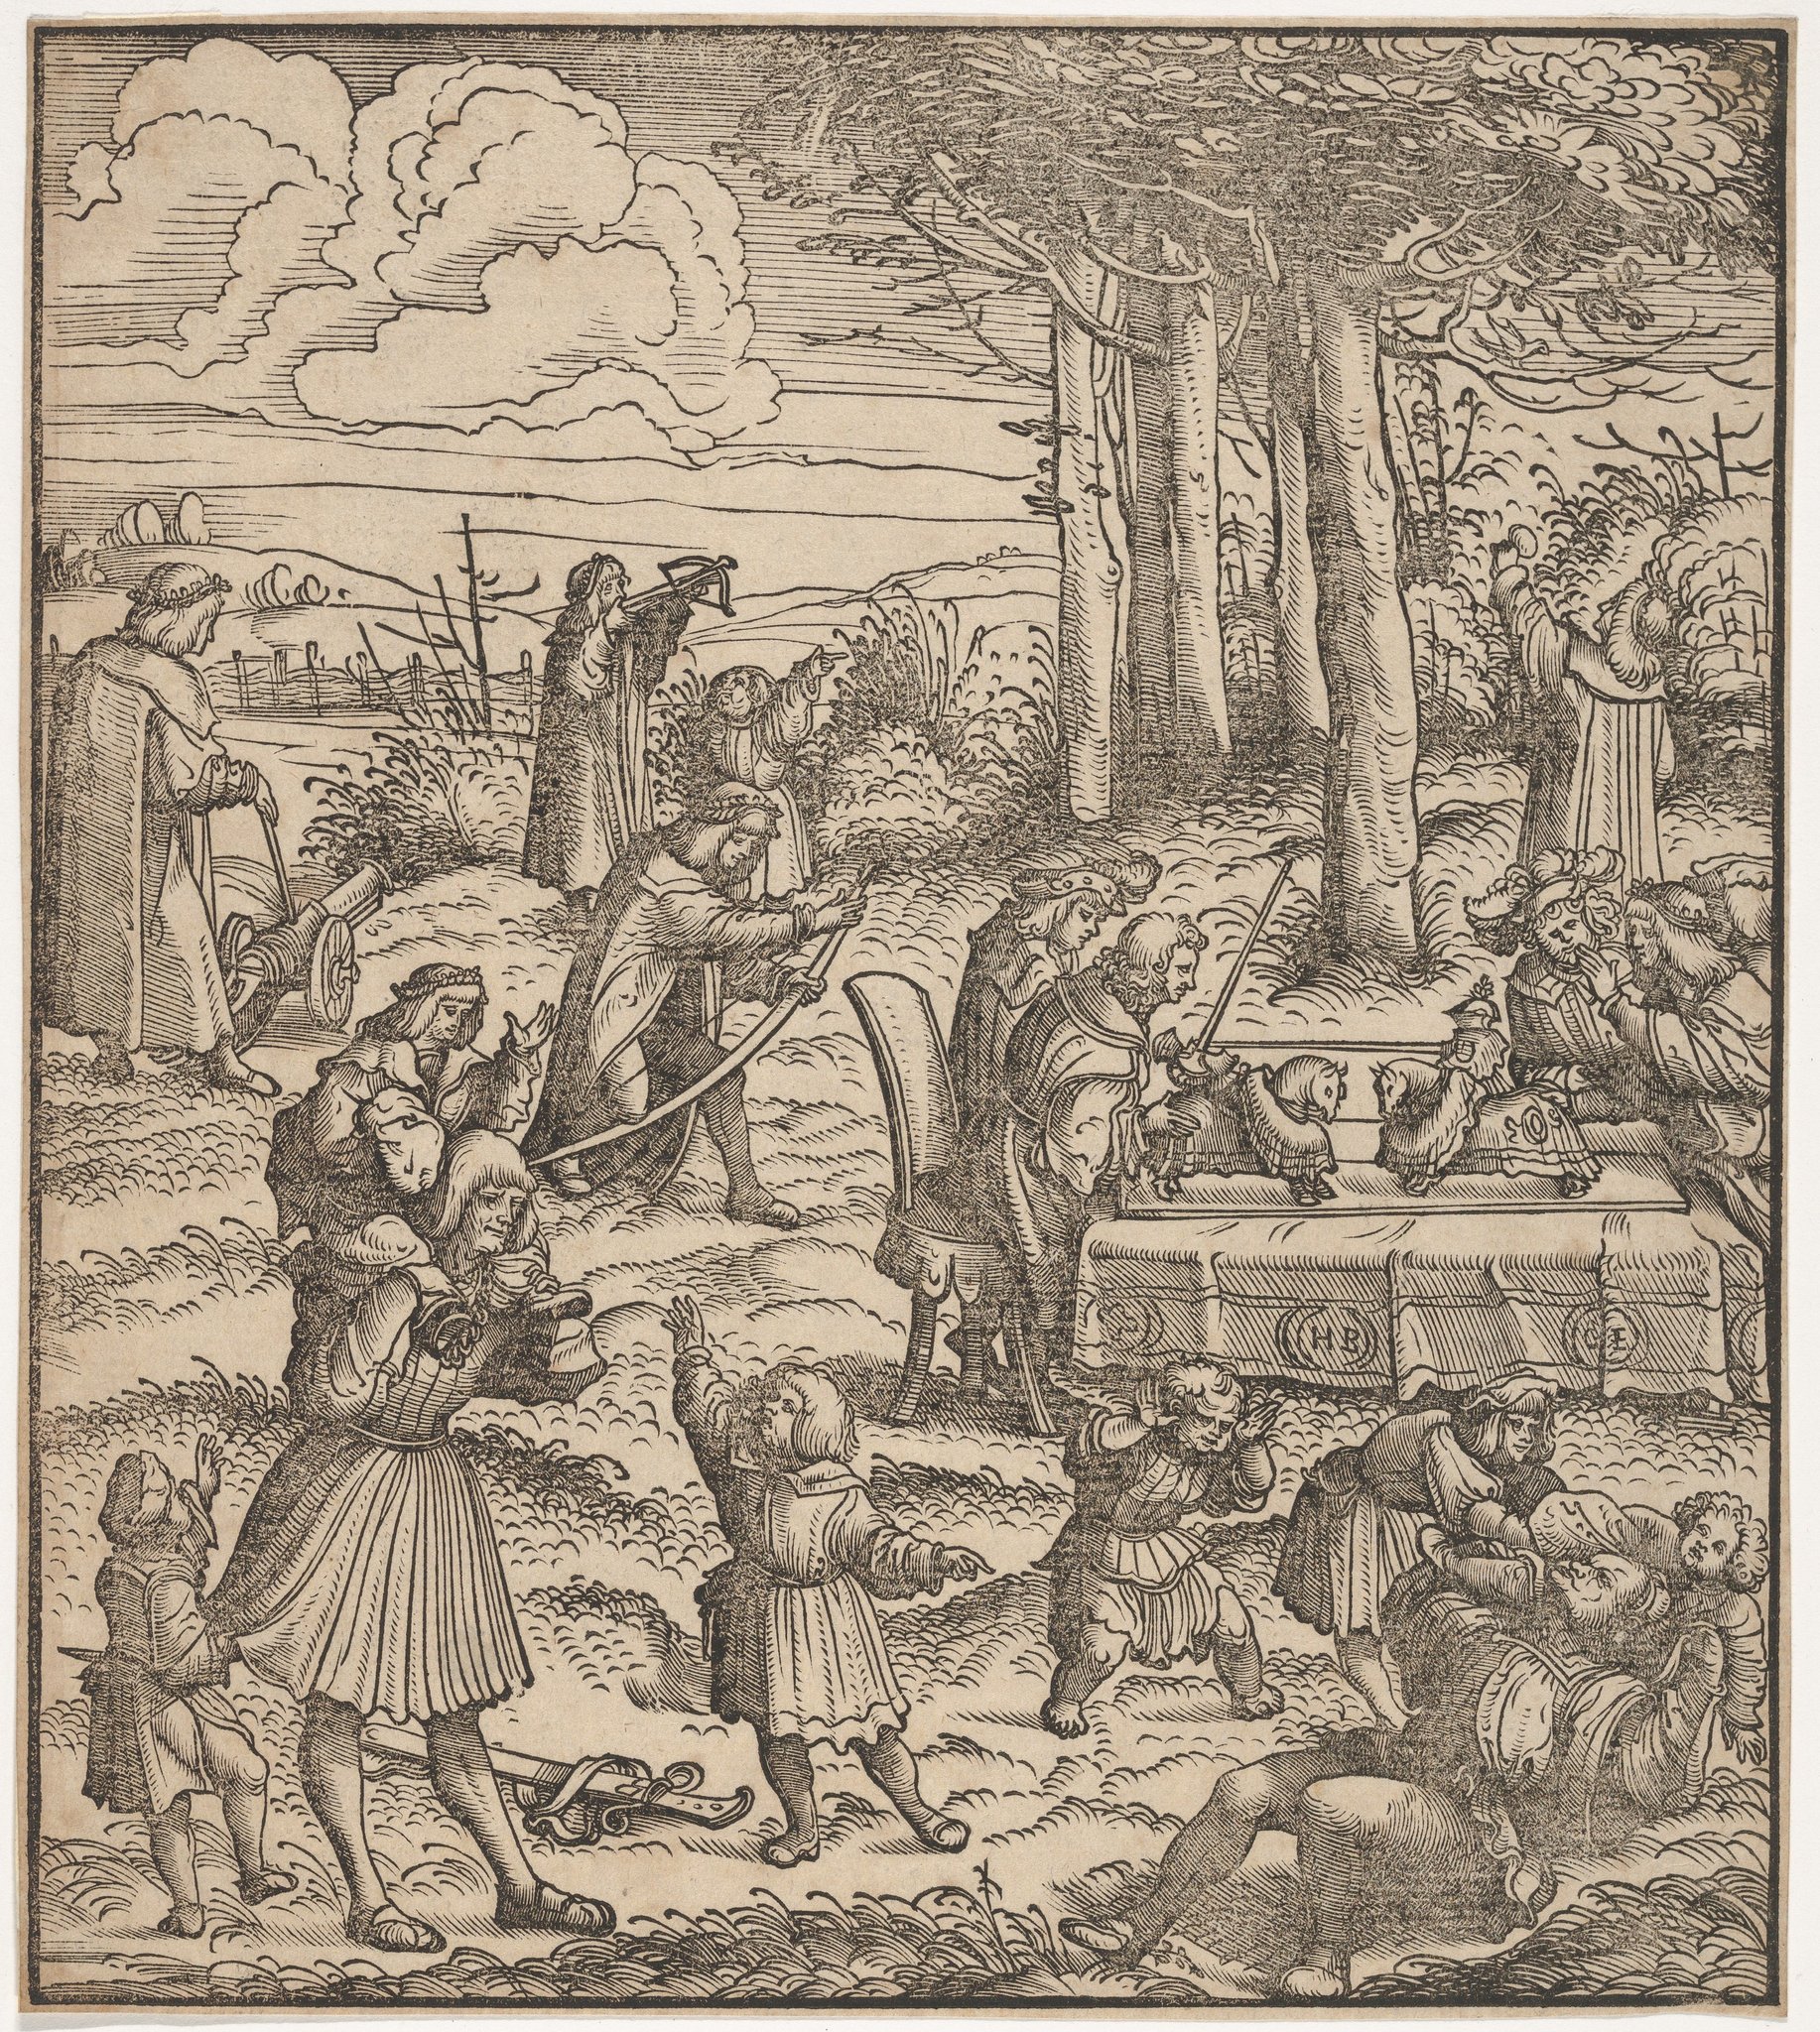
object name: print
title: The White King as Child Playing with Other Children, from Der Weisskunig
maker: hans burgkmair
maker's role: artist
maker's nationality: german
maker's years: 1473-1531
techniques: woodcut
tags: kings,boys,girls,men,women